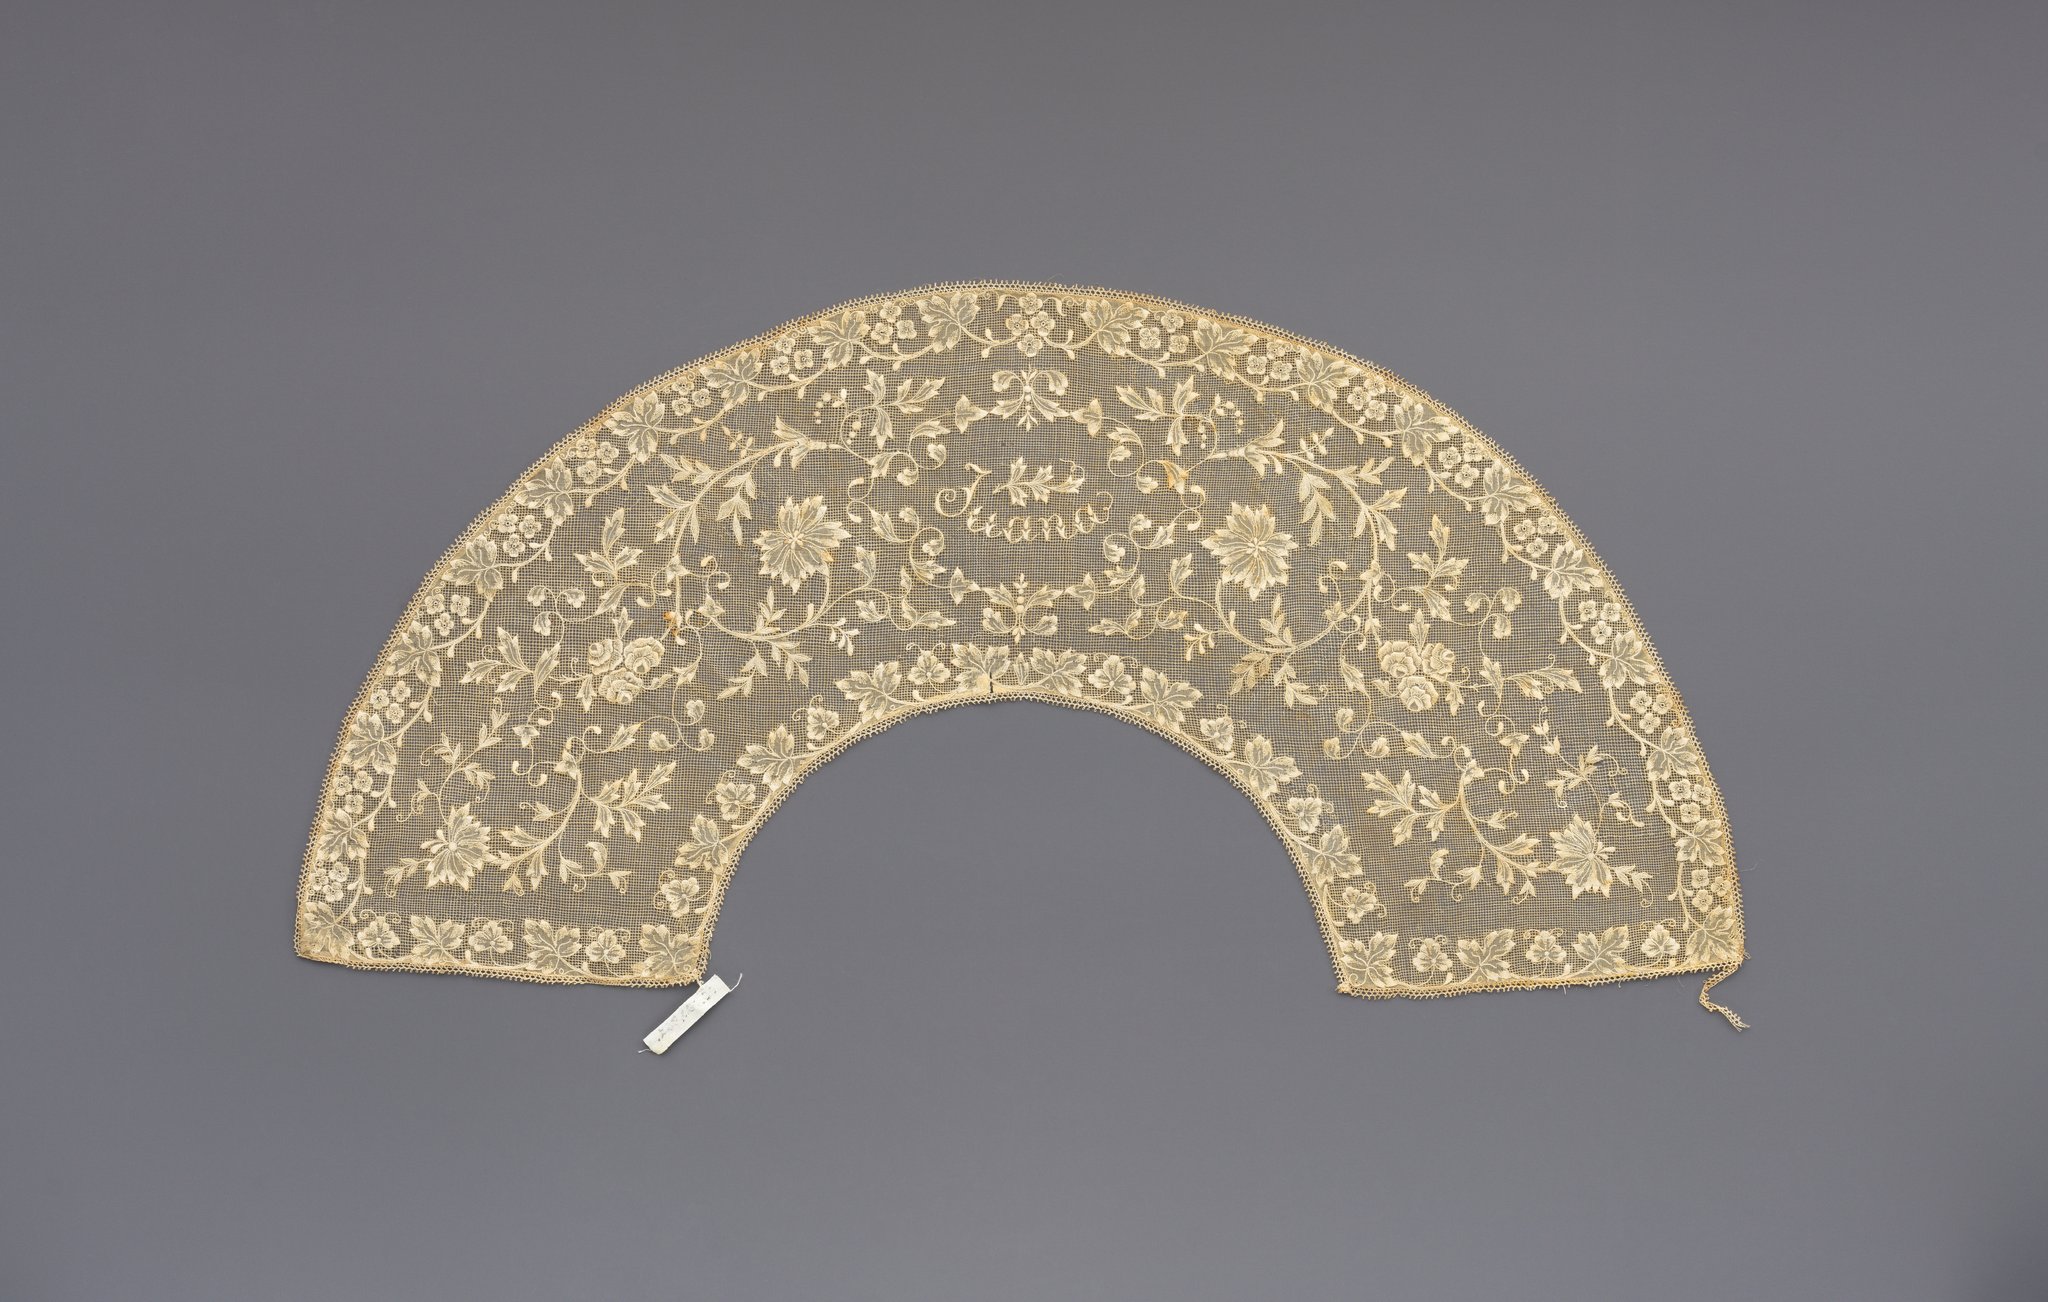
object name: fan leaf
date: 1801-1900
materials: fiber